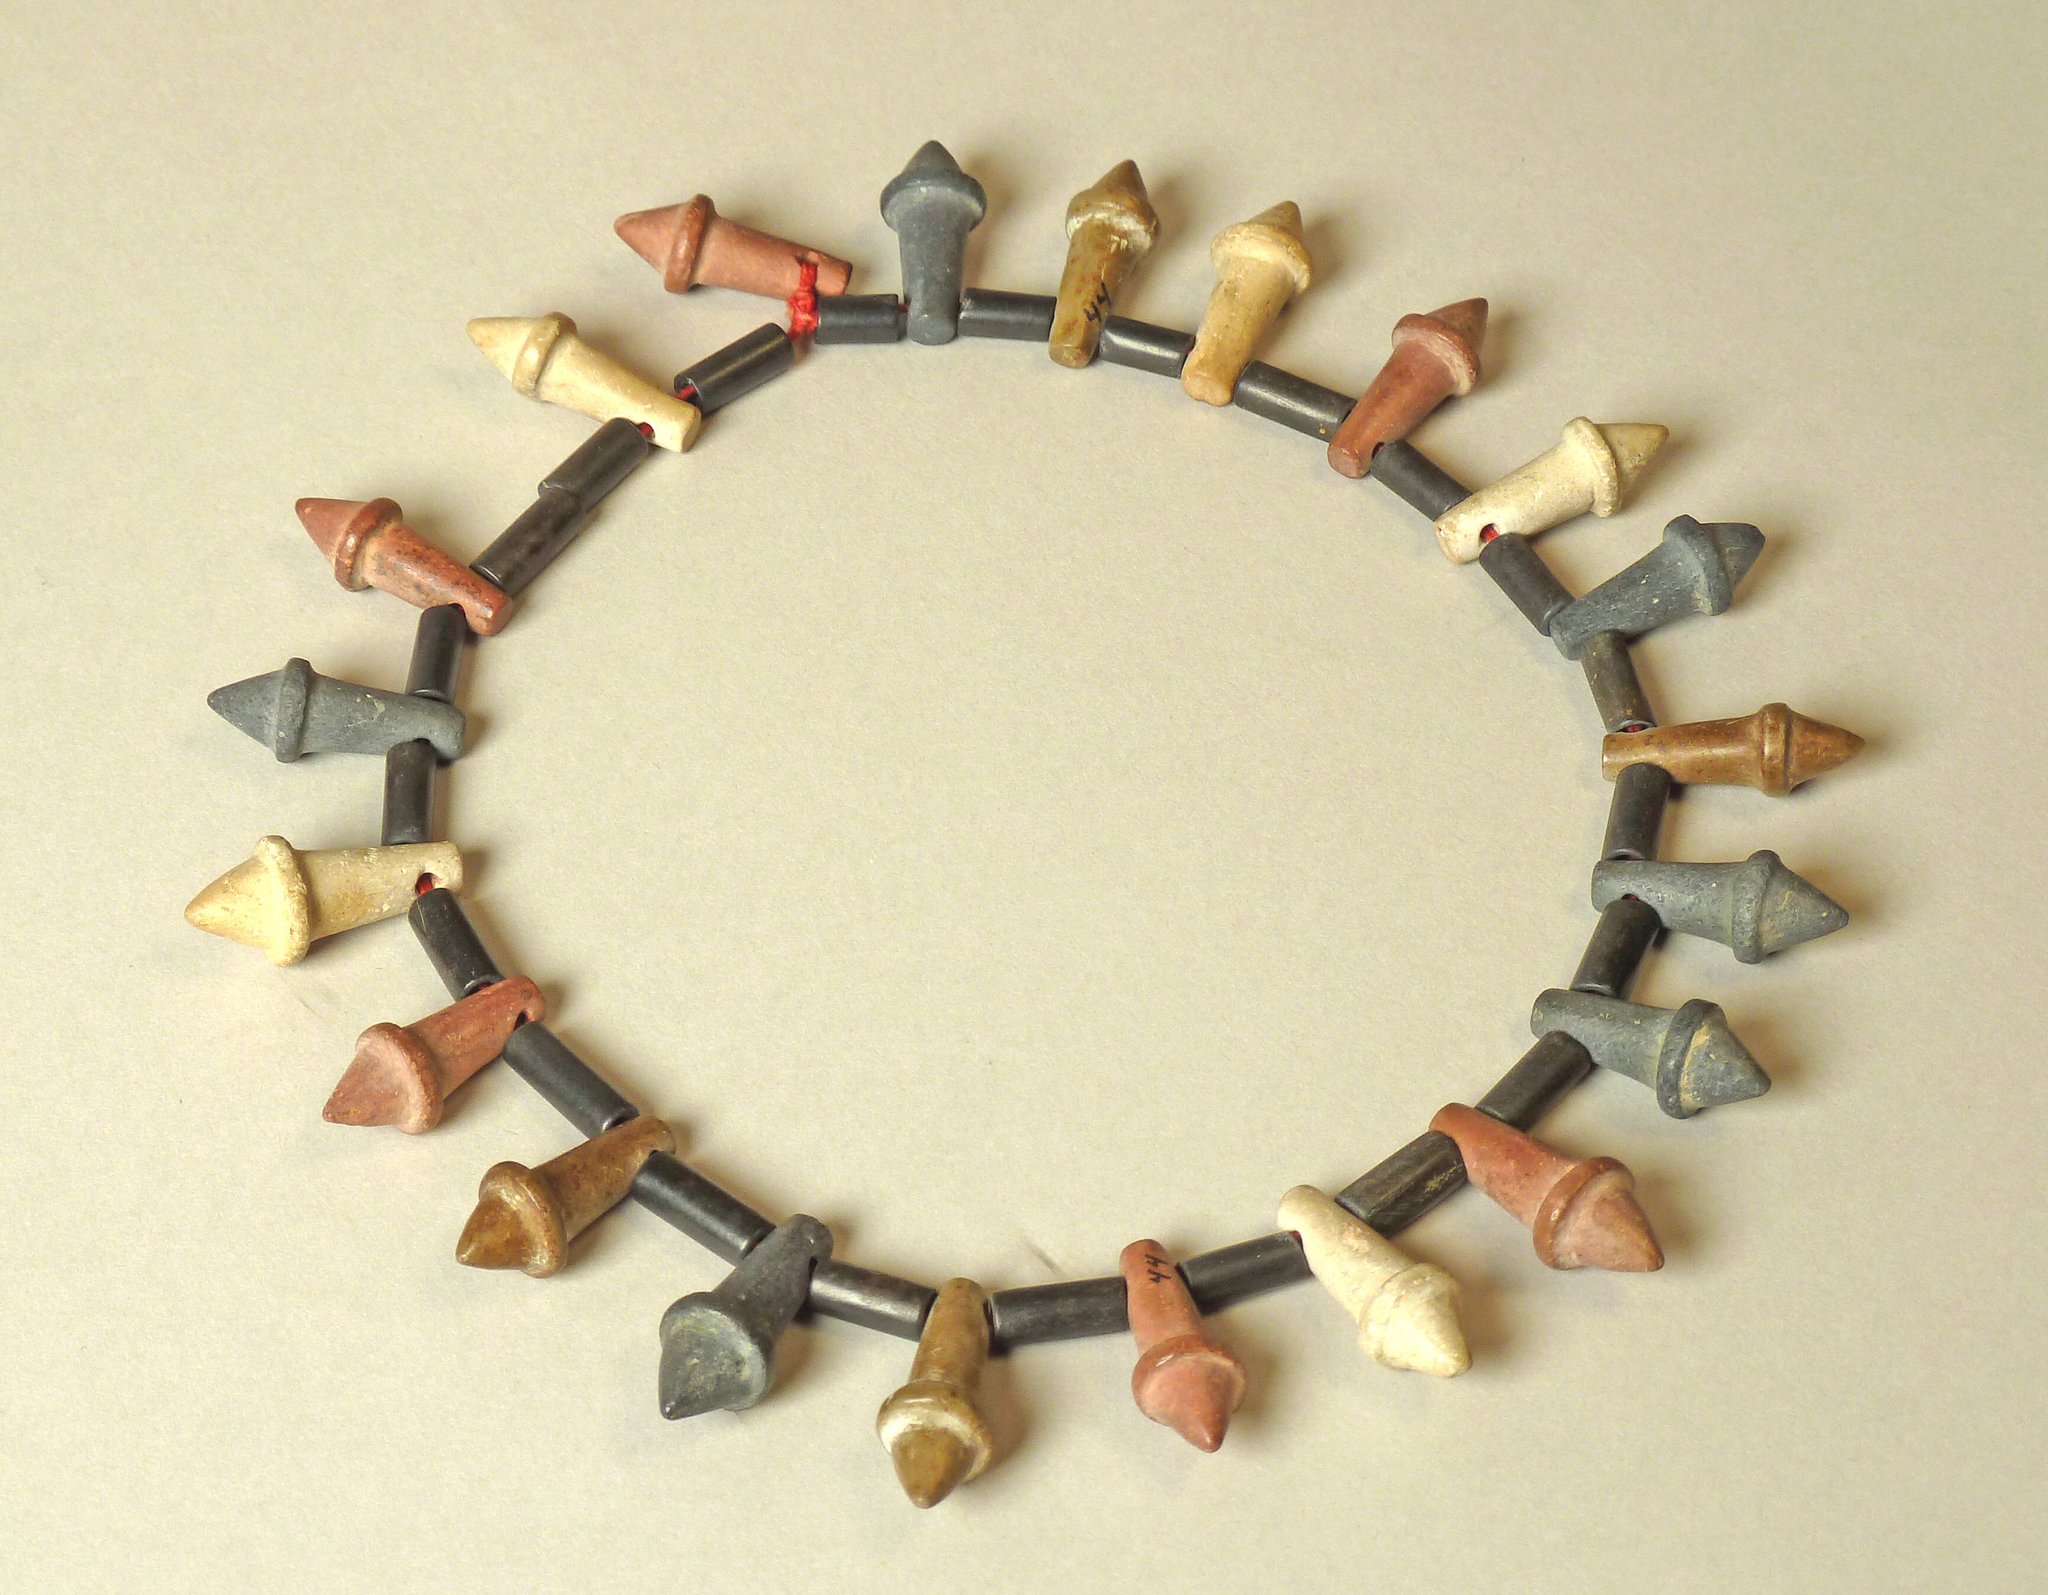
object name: necklace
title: Stone Necklace with Mace Heads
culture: moche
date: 1-500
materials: stone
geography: peru